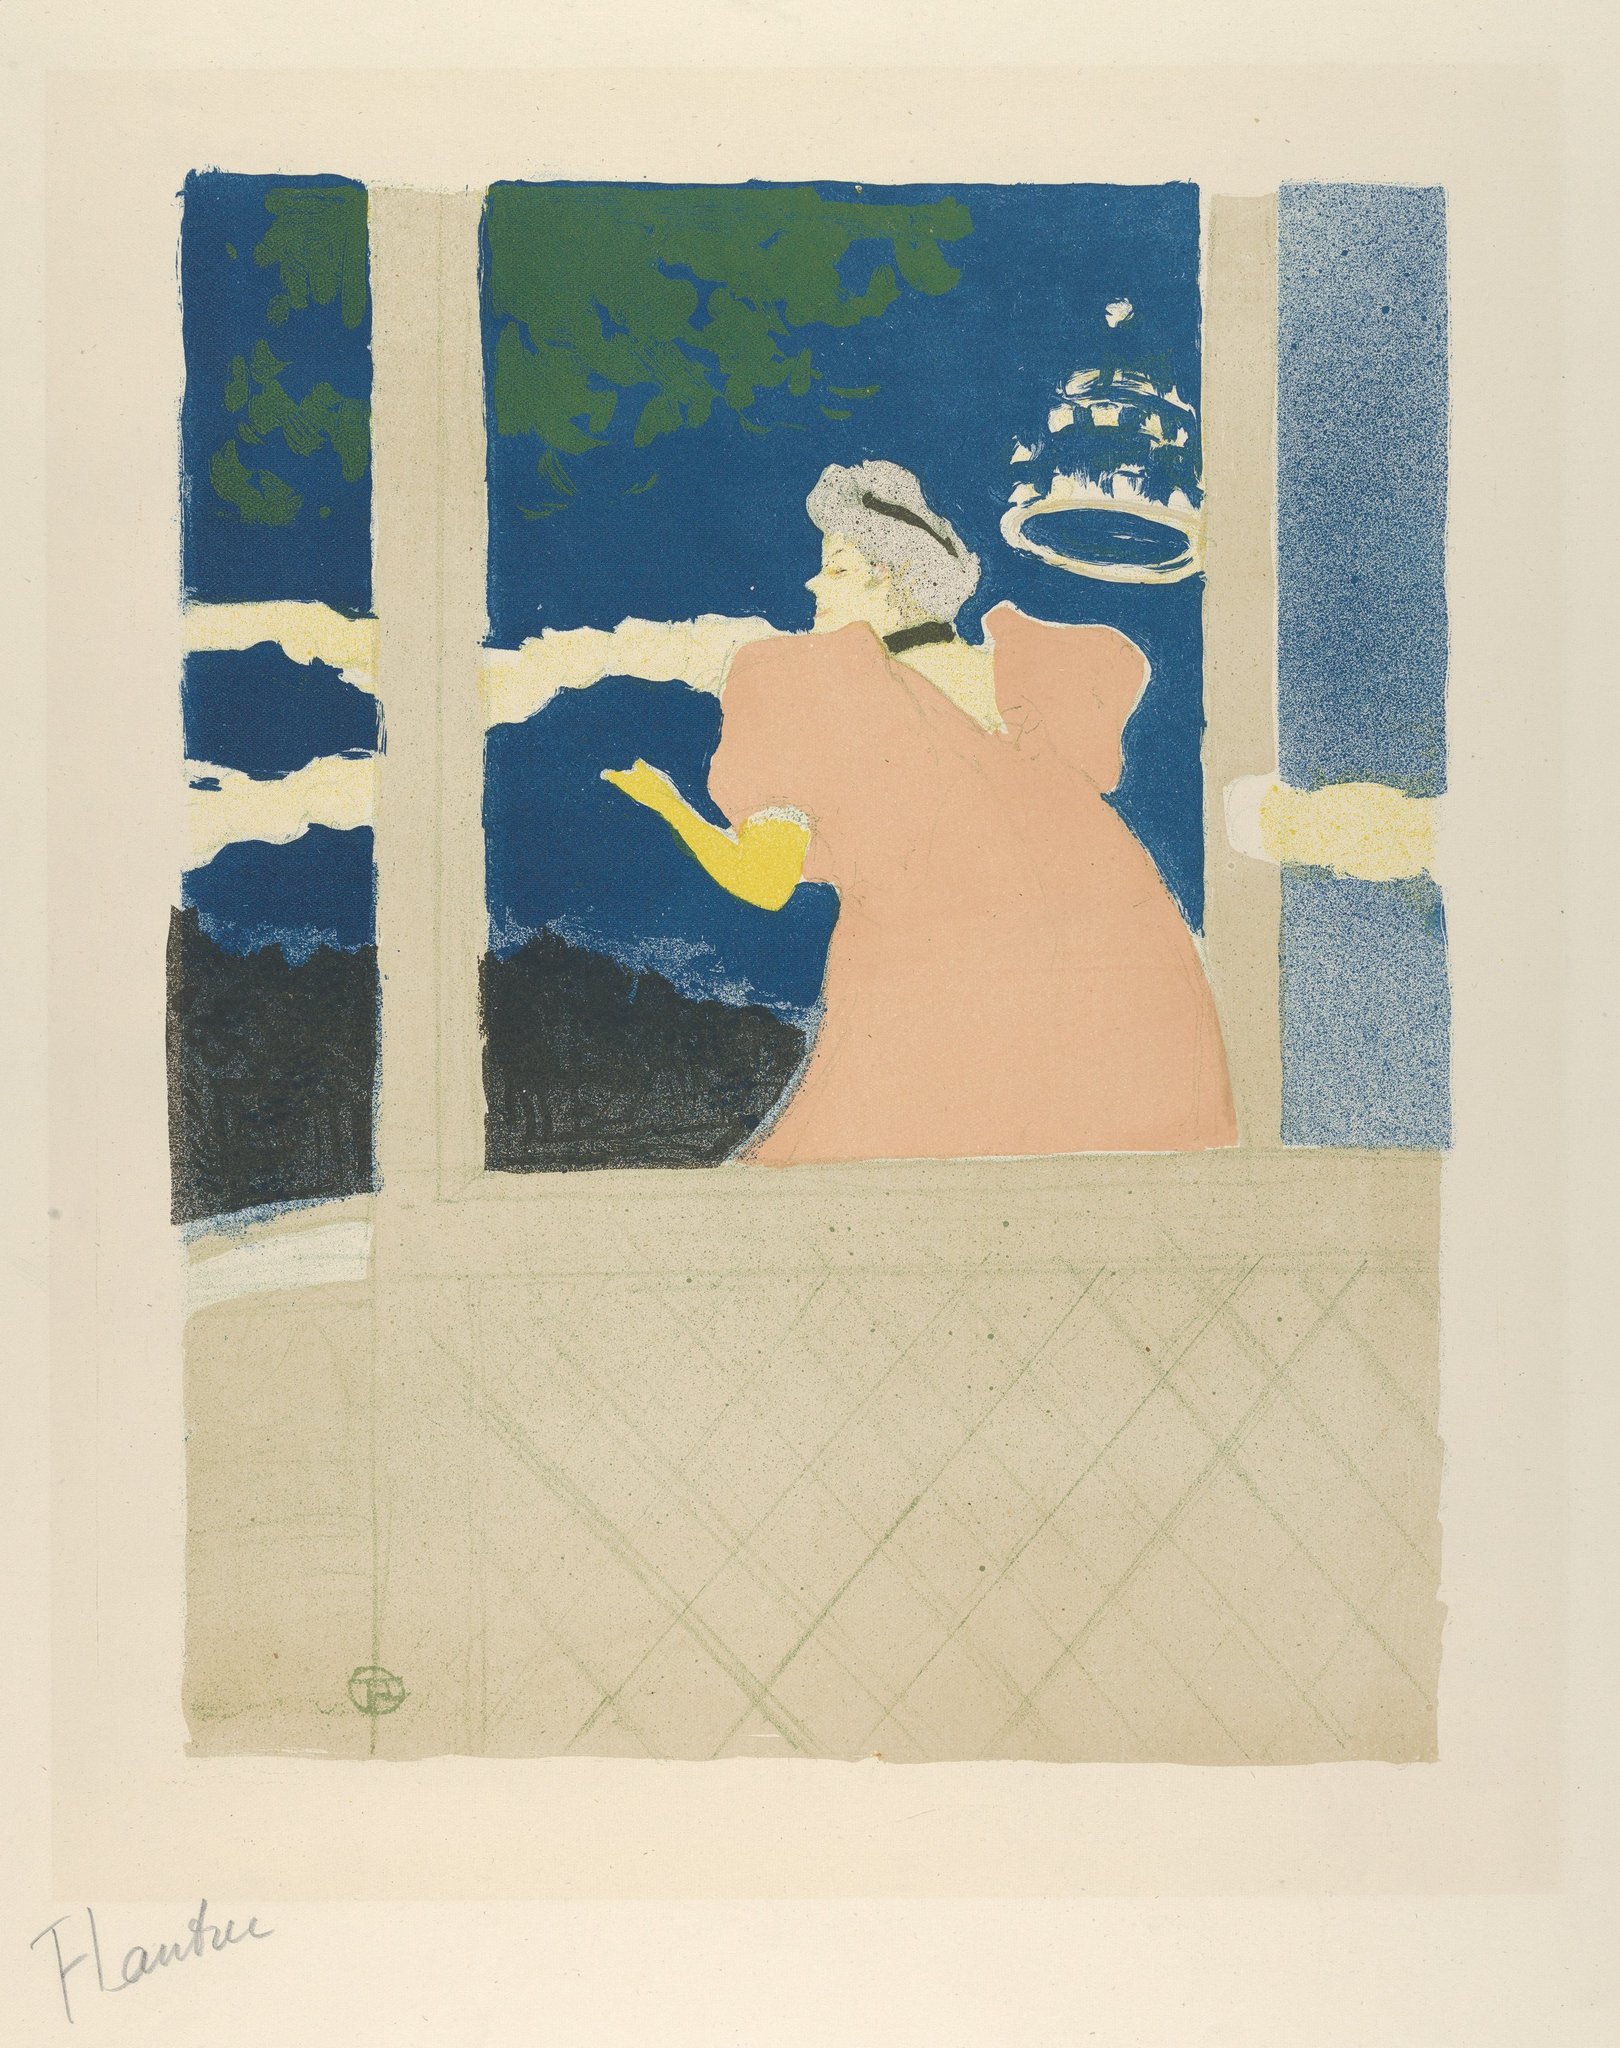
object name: print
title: At Les Ambassadeurs (Au Café-Concert / At the Café Concert), from "L'Estampe Originale"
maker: henri de toulouse-lautrec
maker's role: artist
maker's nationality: french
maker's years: 1864-1901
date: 1894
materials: crayon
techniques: brush, lithograph, printing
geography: france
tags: women